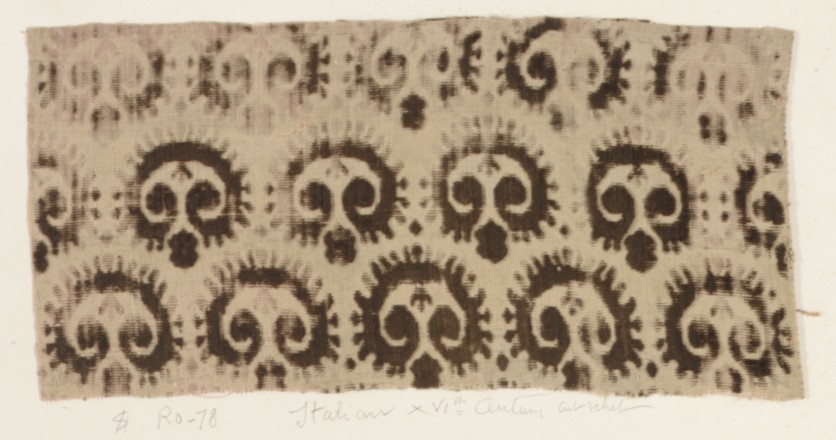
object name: fragment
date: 1501-1600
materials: silk